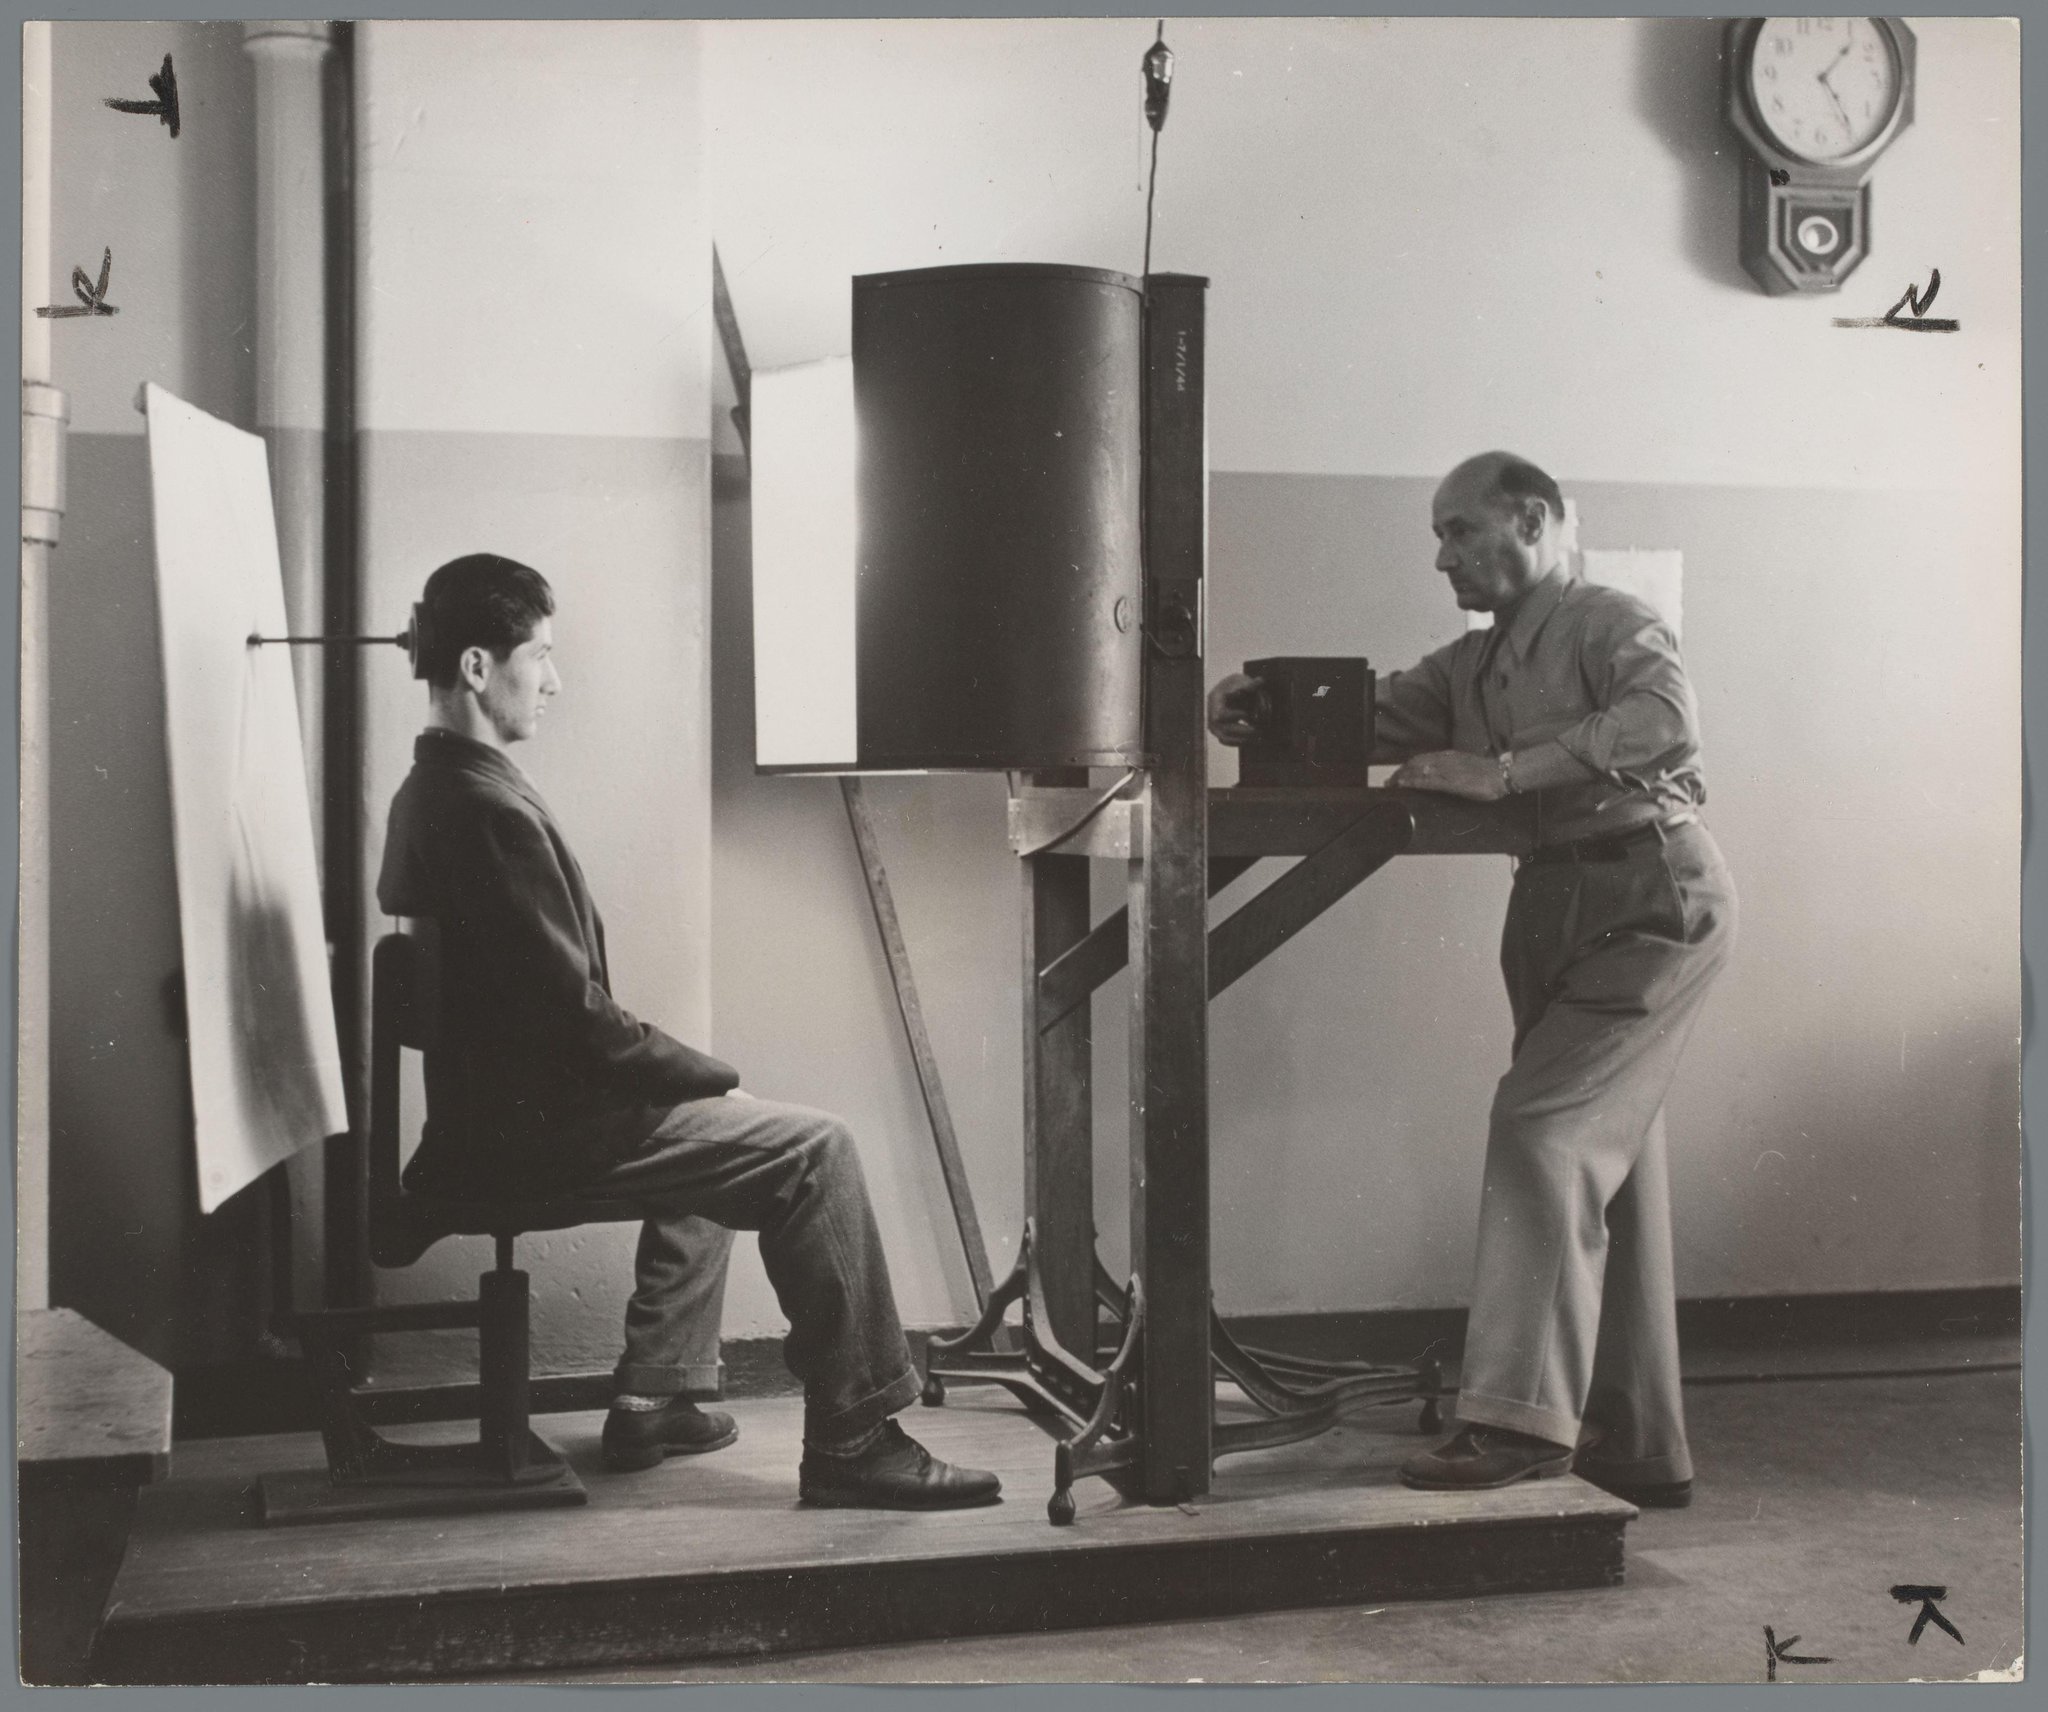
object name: photograph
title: Anoniem, Vreemdeling (‘alien’) die in Ellis Island wordt gefotografeerd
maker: Anonymous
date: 1949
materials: photographic support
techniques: gelatin silver print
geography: ellis island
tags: ellis island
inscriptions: label: ‘4823 / ellis island / FREE PHOTO – After being booked, deportees are photographed / and fingerprinted. Here an alien has his picture taken by / Security officer Harry Goodman, who doesn’t bother asking his / customer to watch the birdie.’, stamp: ‘METRO GROUP EDITORIAL SERVICE […]’, stamp: ‘JUL 17 1949’, stamp: ‘NOV 4 1949’